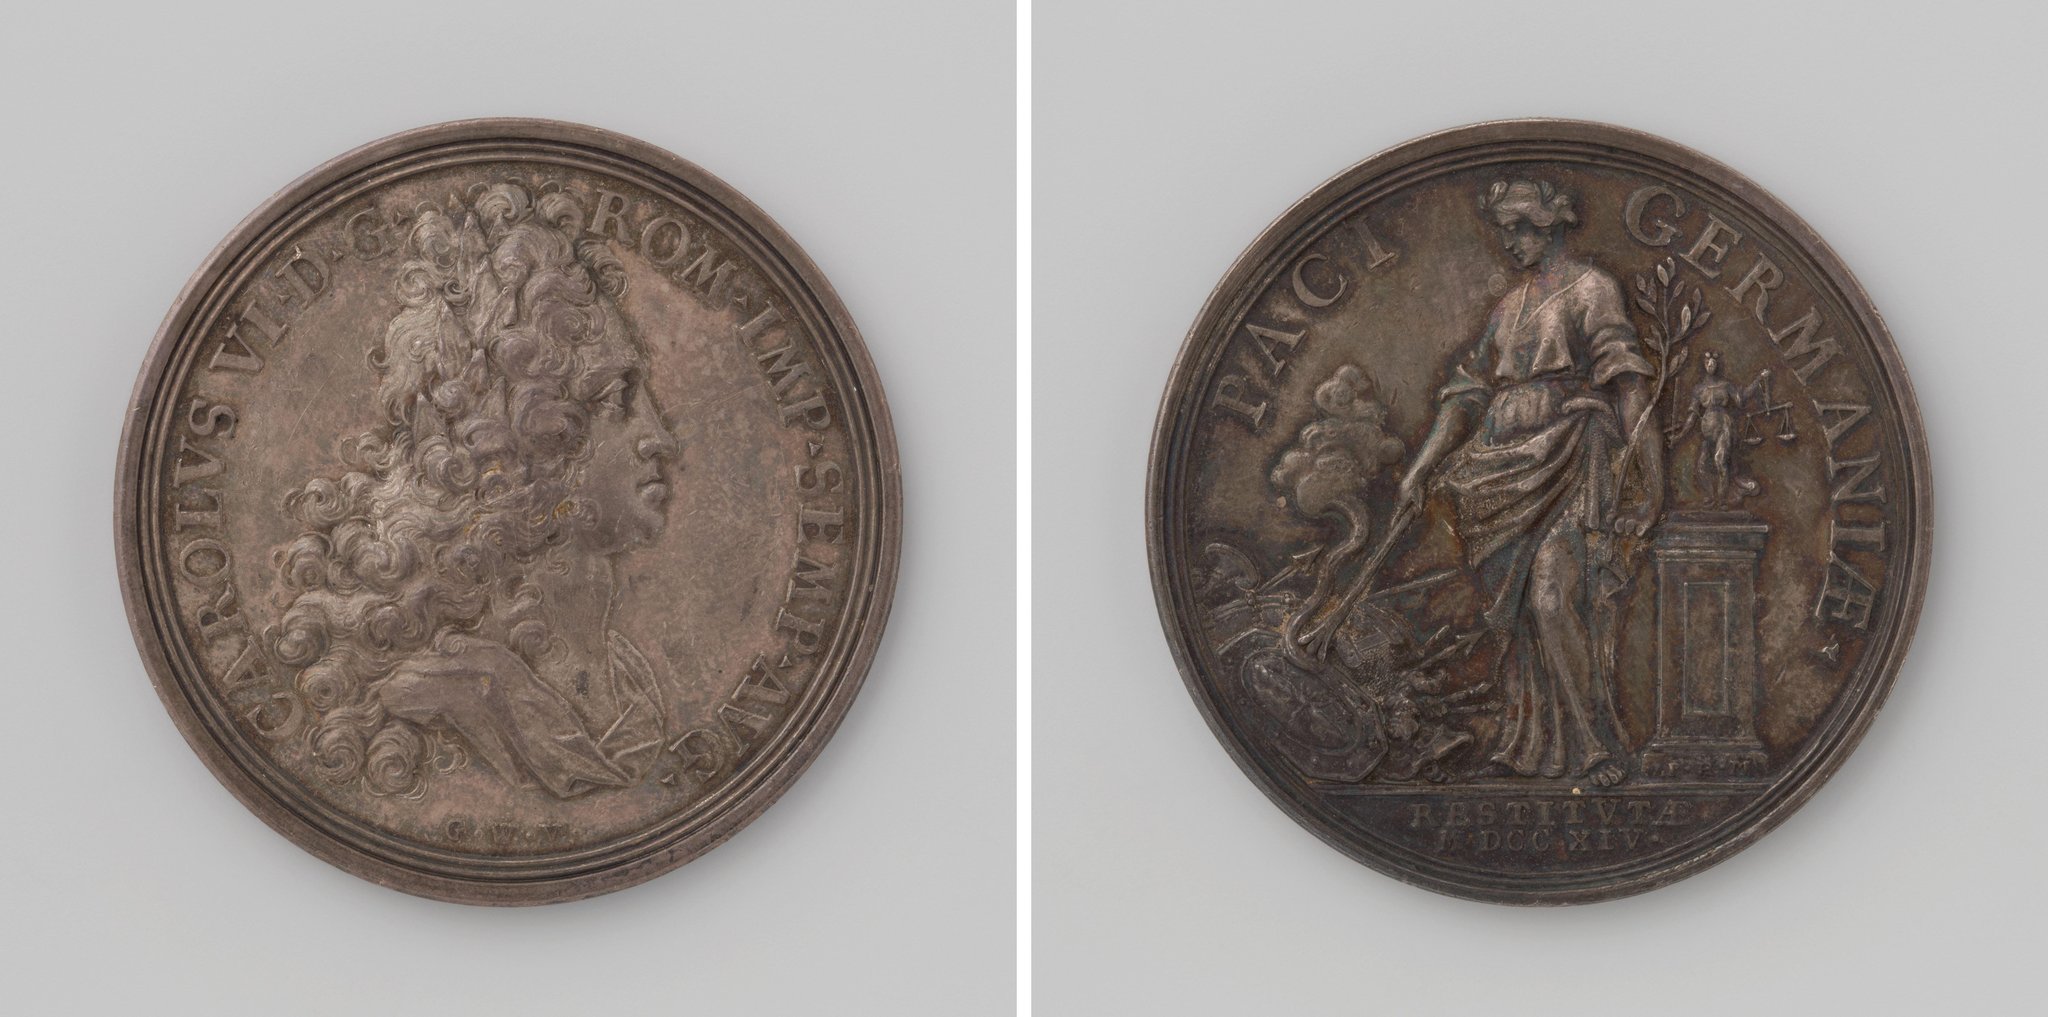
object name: history medal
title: Vrede van Baden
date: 1714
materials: silver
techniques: striking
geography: nuremberg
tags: vienna, charles vi (holy roman emperor), switzerland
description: Zilveren penning. Voorzijde: borststuk man met lauwerkrans binnen omschrift. Keerzijde: Vrede met olijftak in hand steekt met een fakkel stapel wapentuig in brand, staande naast voetstuk waarop Gerechtigheid staat binnen omschrift; afsnede: opschrift